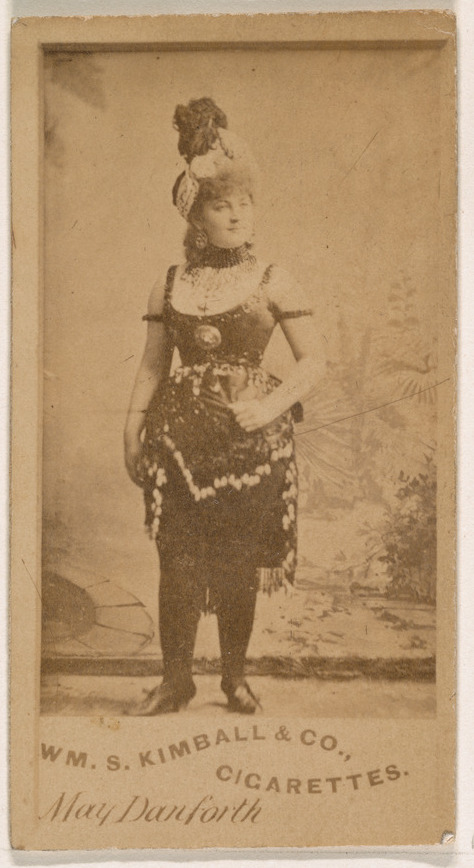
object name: photograph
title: May Danforth, from the Actresses series (N203) issued by Wm. S. Kimball & Co.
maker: william s. kimball & company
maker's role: publisher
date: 1889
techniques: color lithograph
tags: portraits,women,actresses